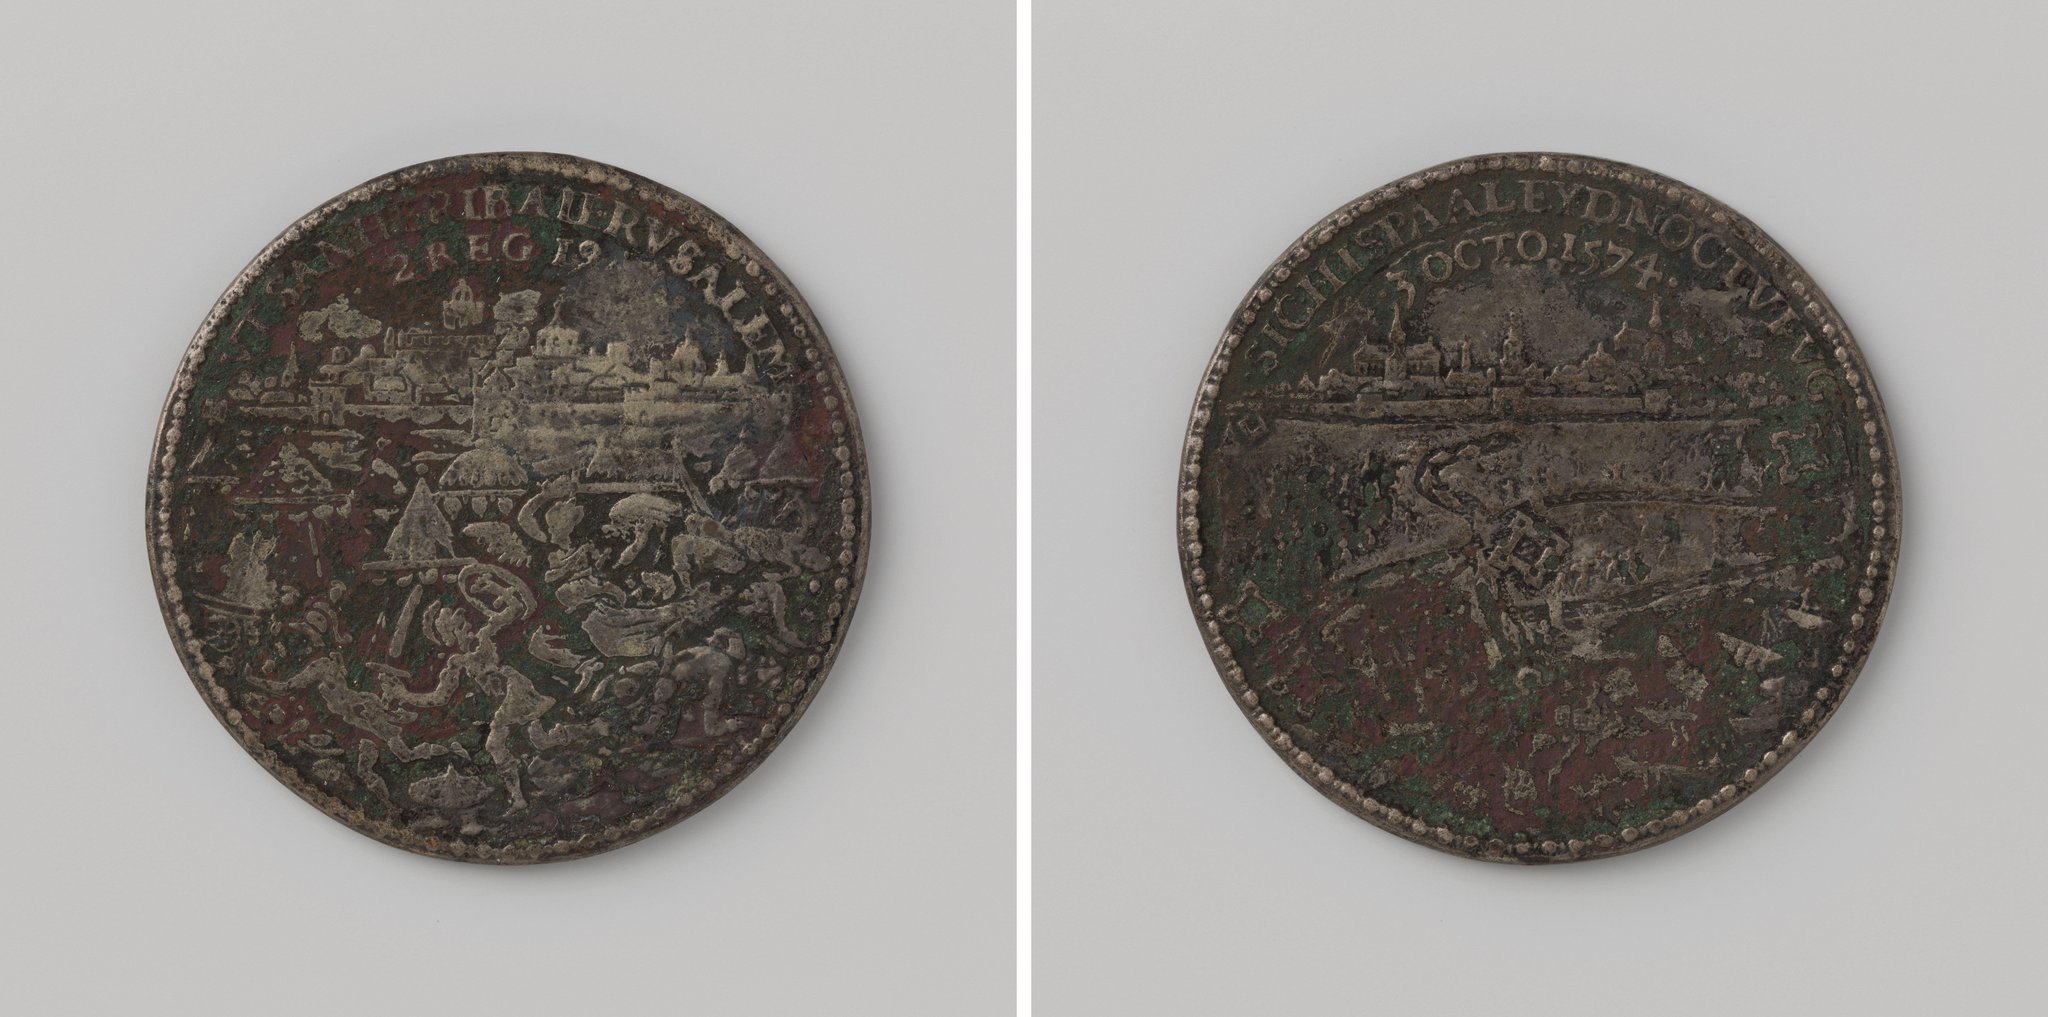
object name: history medal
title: Ontzet van Leiden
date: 1574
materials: silver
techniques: striking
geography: dordrecht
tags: leiden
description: Zilveren penning. Voorzijde: beleg van Jeruzalem door de koning van Assyrie, wiens soldaten uit tentenkamp vluchten voor een engel met getrokken zwaard binnen omschrift. Keerzijde: gezicht op stad Leiden boven plattegrond met vestingwerken en aftocht van belegeraars binnen omschrift